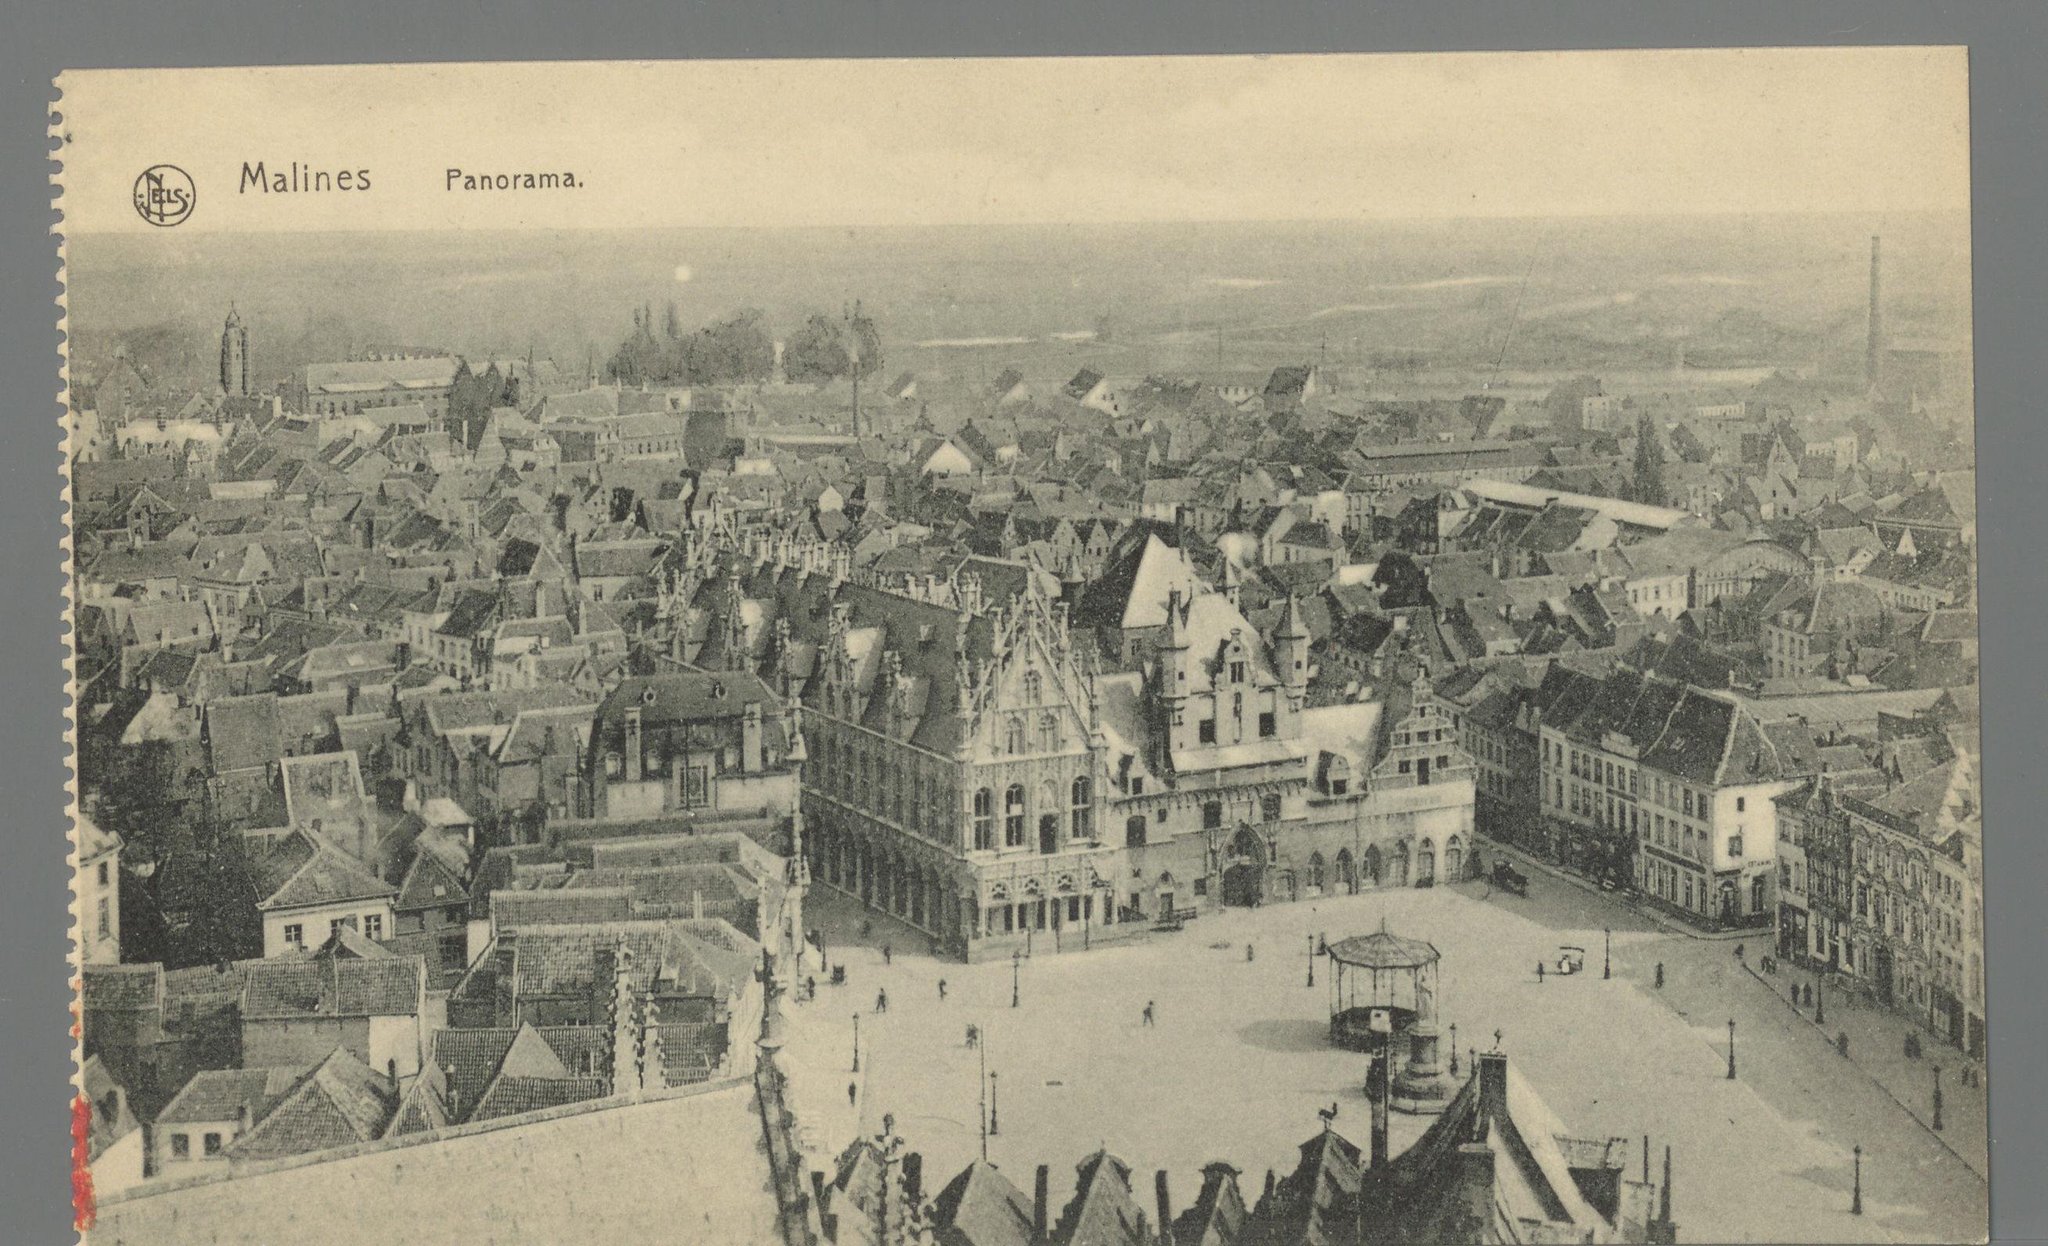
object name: ansichtkaart, prentbriefkaart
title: Malines. Panorama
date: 1913-1914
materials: cardboard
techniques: photograph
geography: mechelen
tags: square, place, circus, etc. (+ city(-scape) with figures, staffage), prospect of city, town panorama, silhouette of city, mechelen